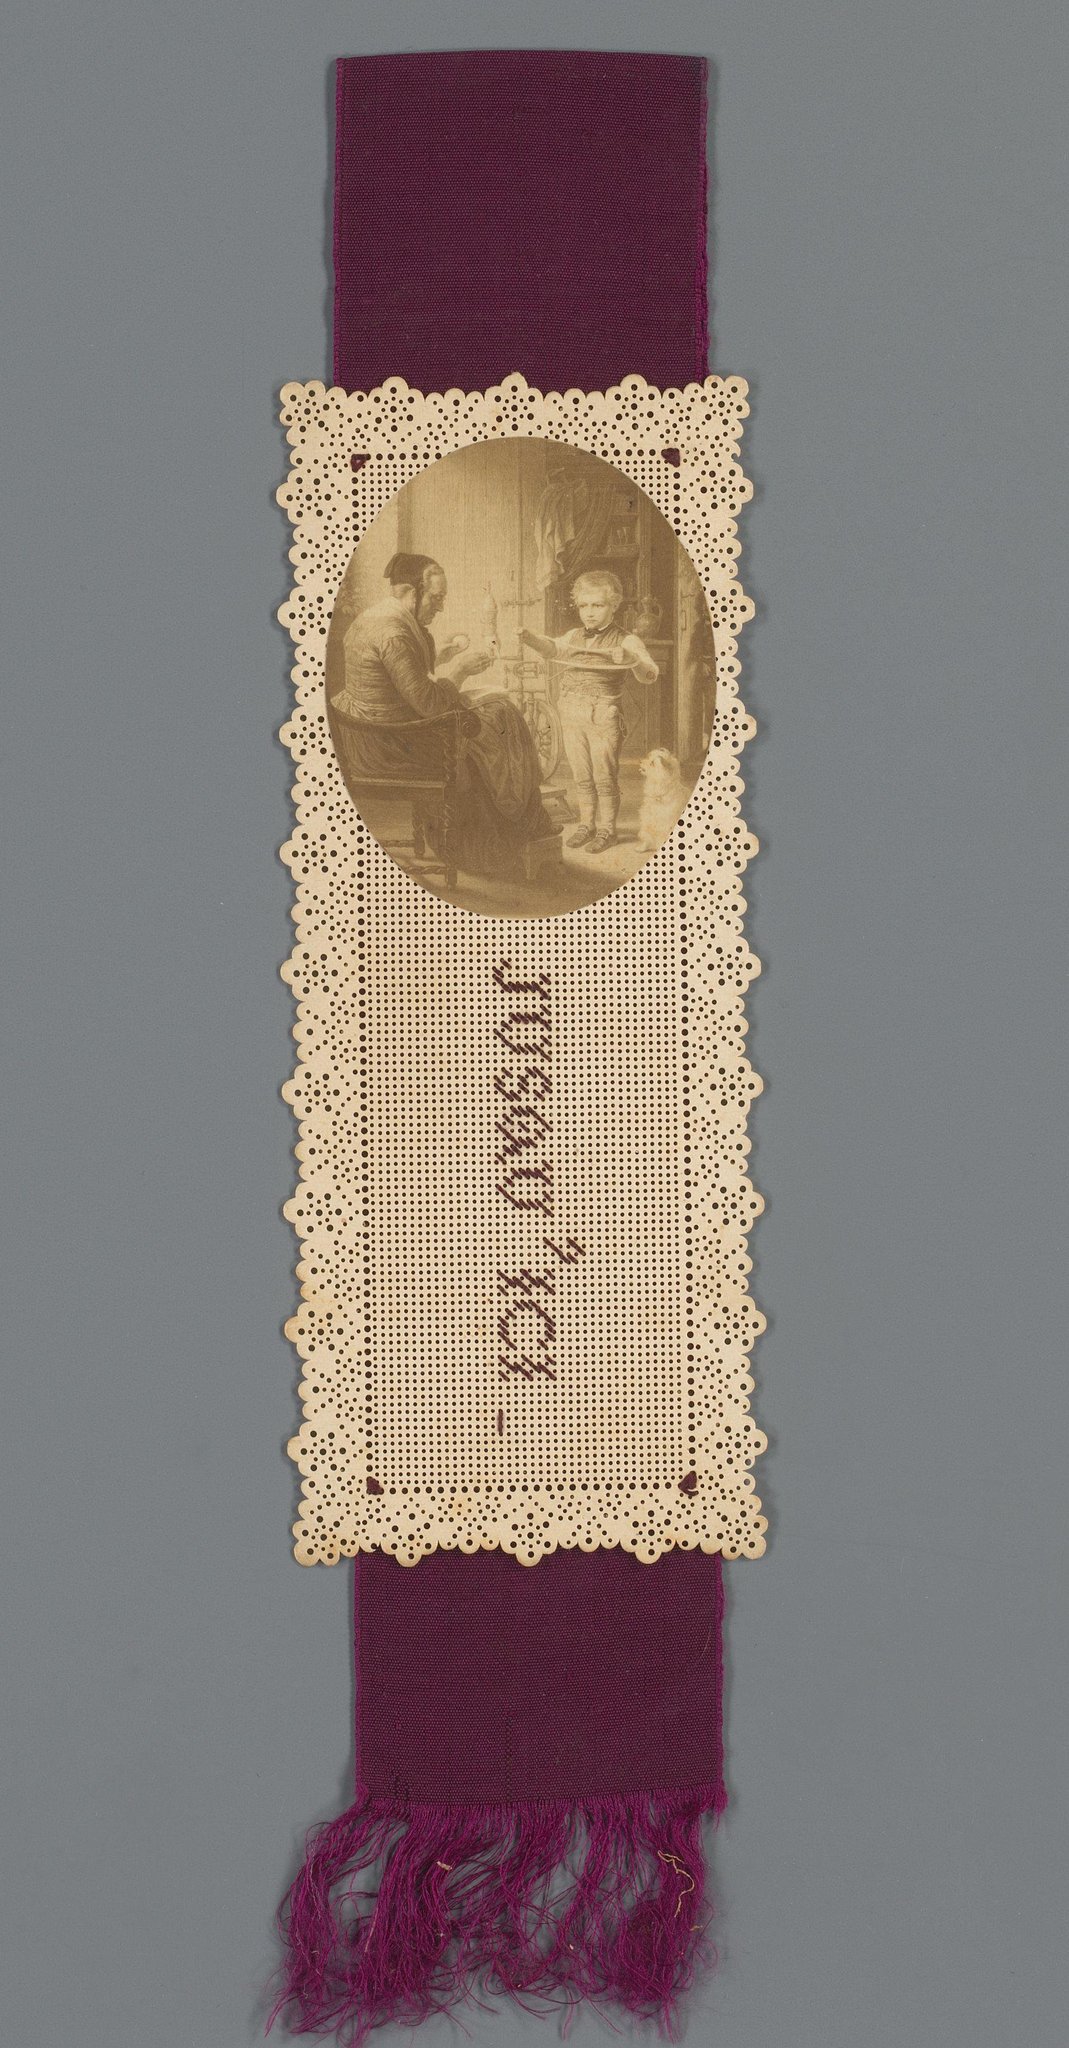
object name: bookmark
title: Boekenlegger met borduurwerk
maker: Anonymous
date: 1880-1980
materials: cardboard, paper, silk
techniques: albumen print, embroidered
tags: book-marker, (other forms of) needlework, e.g.: crocheting, knitting, embroidering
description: Boekenlegger met borduurwerk 'Jusau 'ici' op geschubd karton met gestanste gaatjes, met ovale foto van een schilderij van een oma en kind geplakt op strook bordeauxrood zijde.